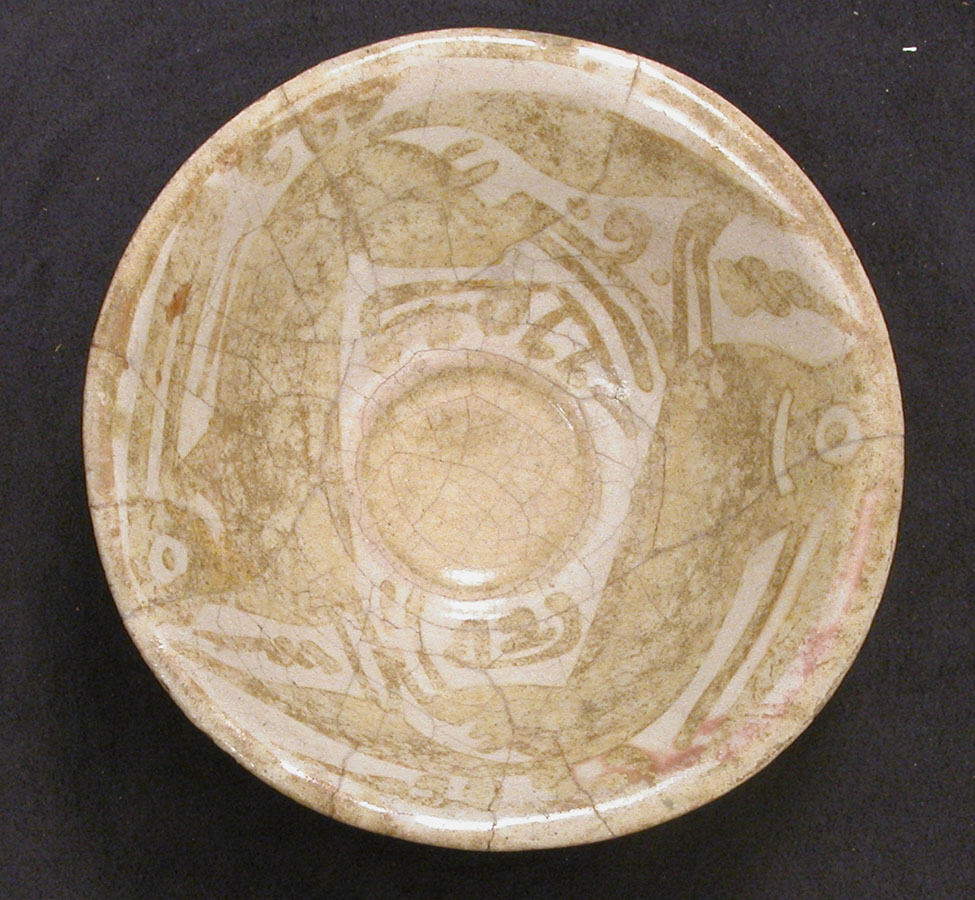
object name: bowl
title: Luster Bowl with Two Running Hares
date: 901-1000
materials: earthenware, glaze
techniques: luster painting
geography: iraq